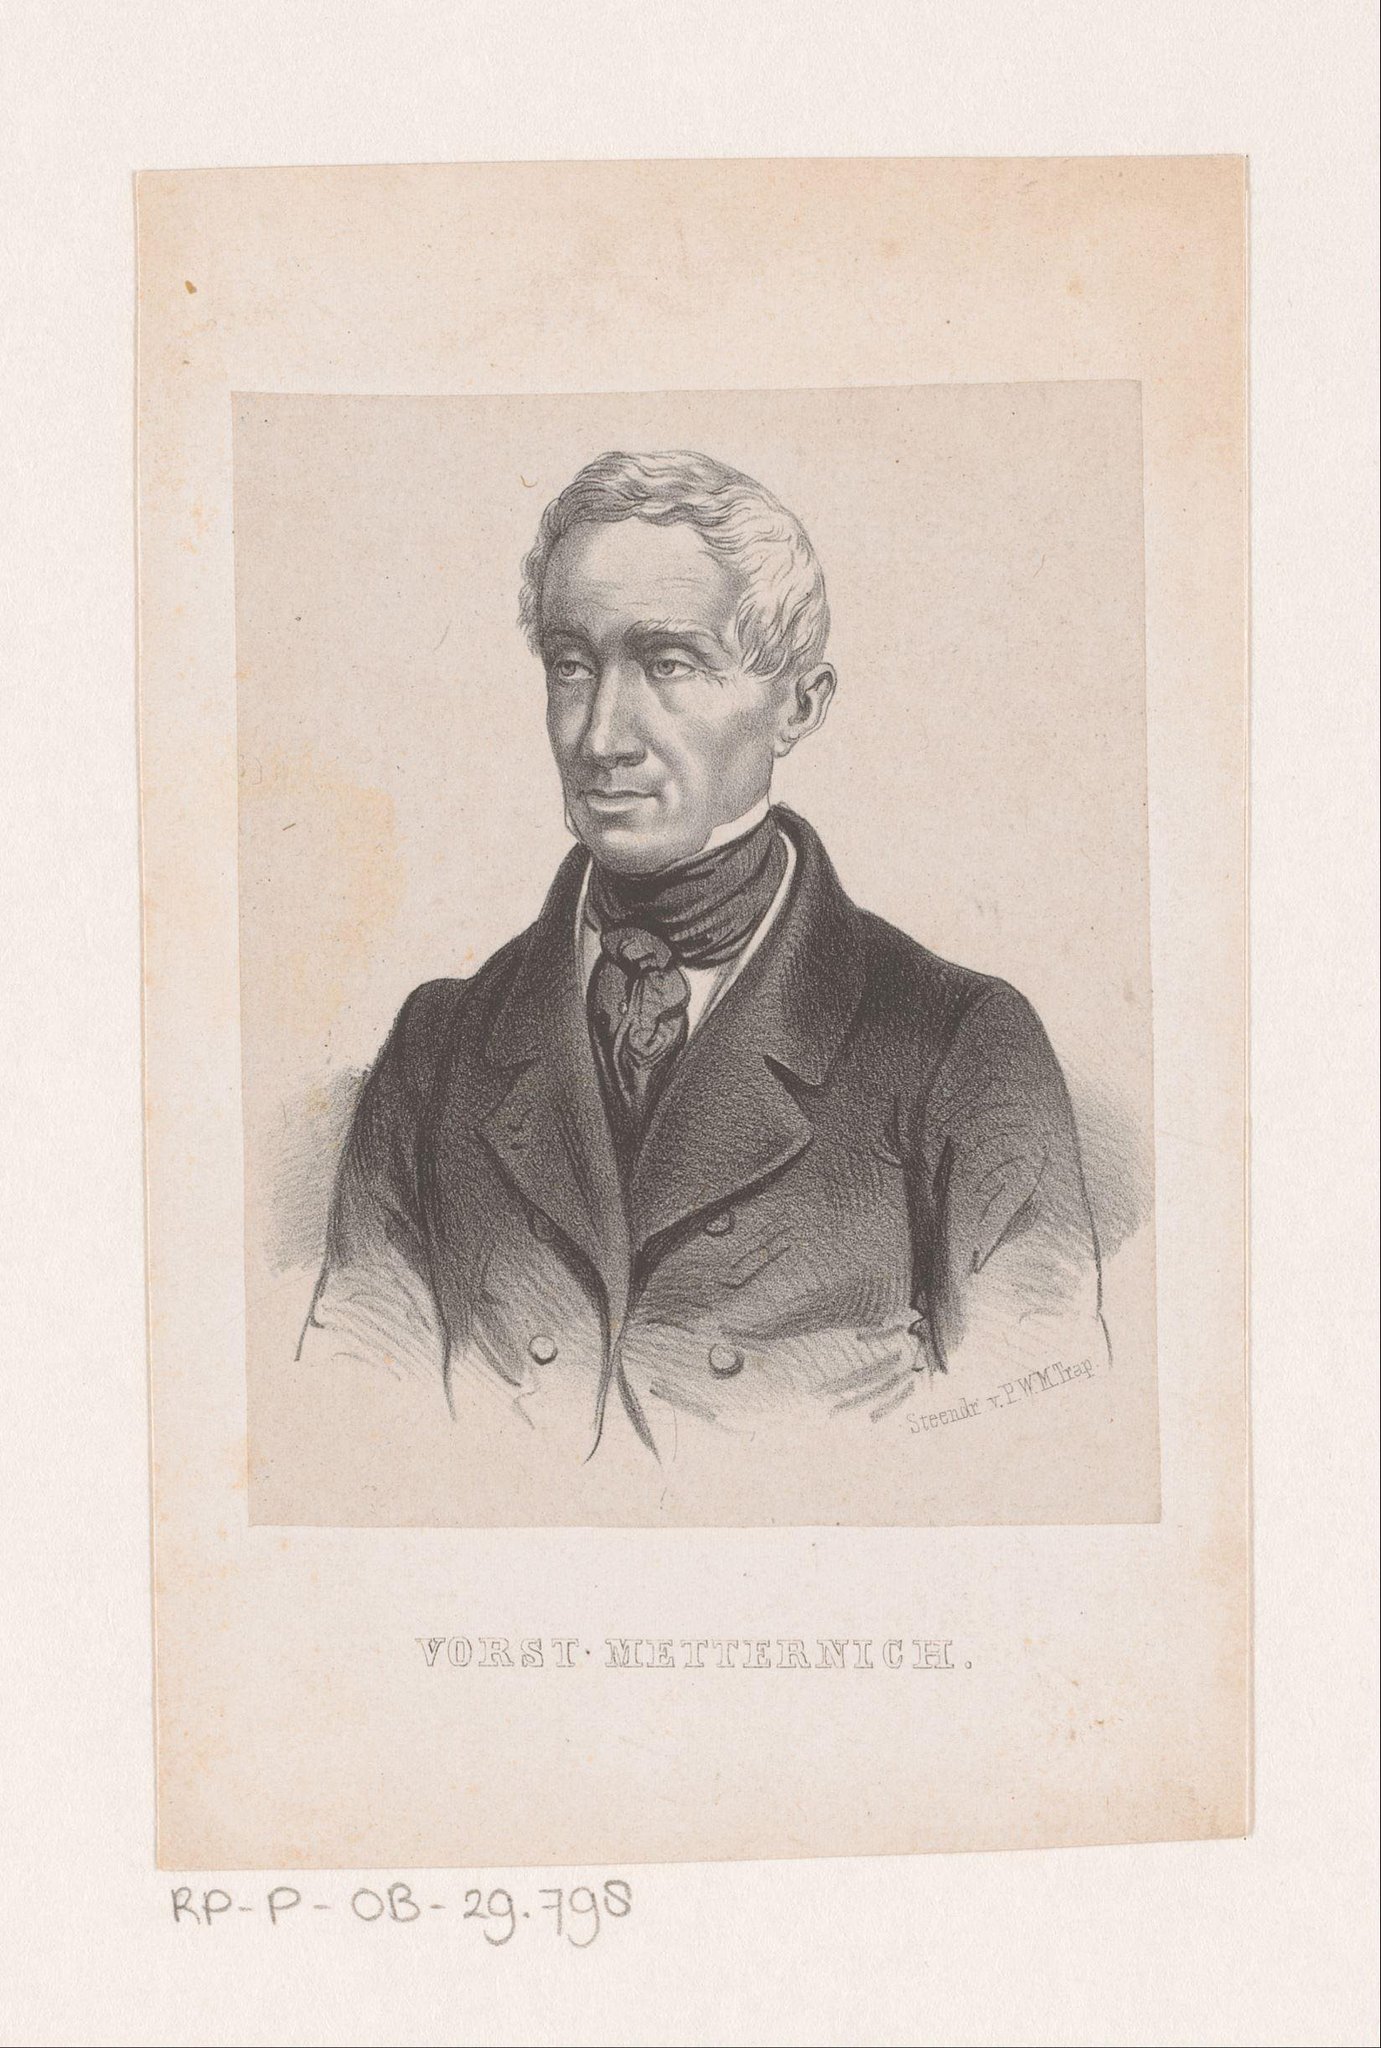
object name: print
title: Portret van de heer Metternich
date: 1836-1905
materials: paper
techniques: lithograph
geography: leiden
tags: historical persons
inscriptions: collector's mark: Lugt 2228